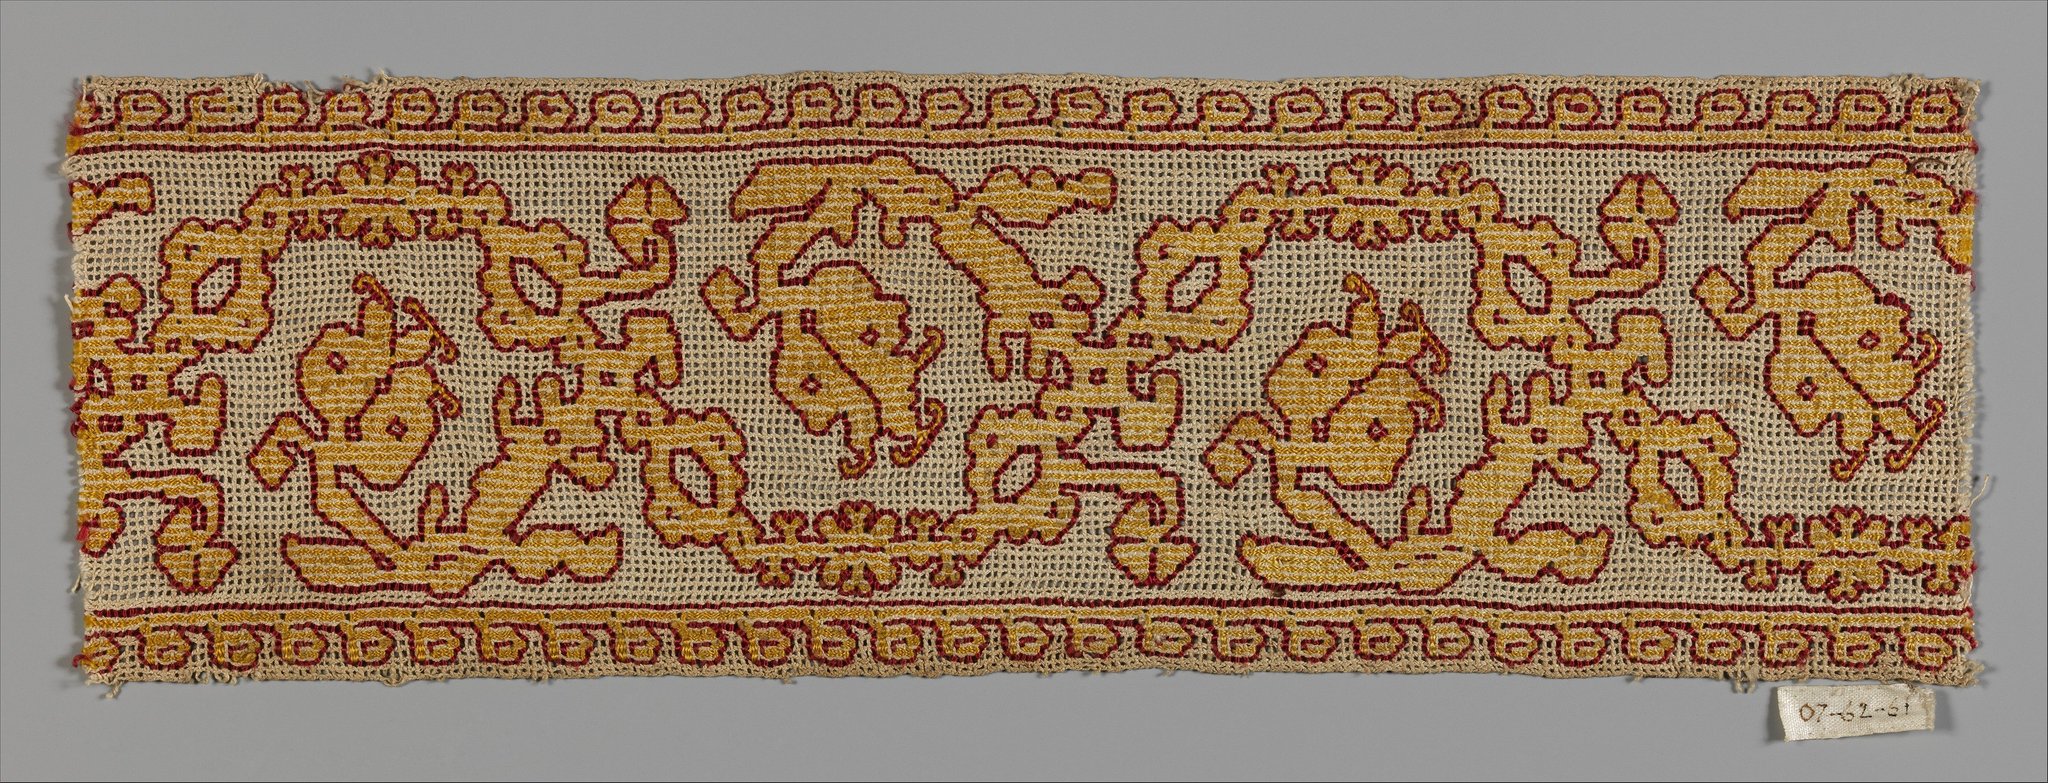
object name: band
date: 1501-1600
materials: linen, silk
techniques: embroidery